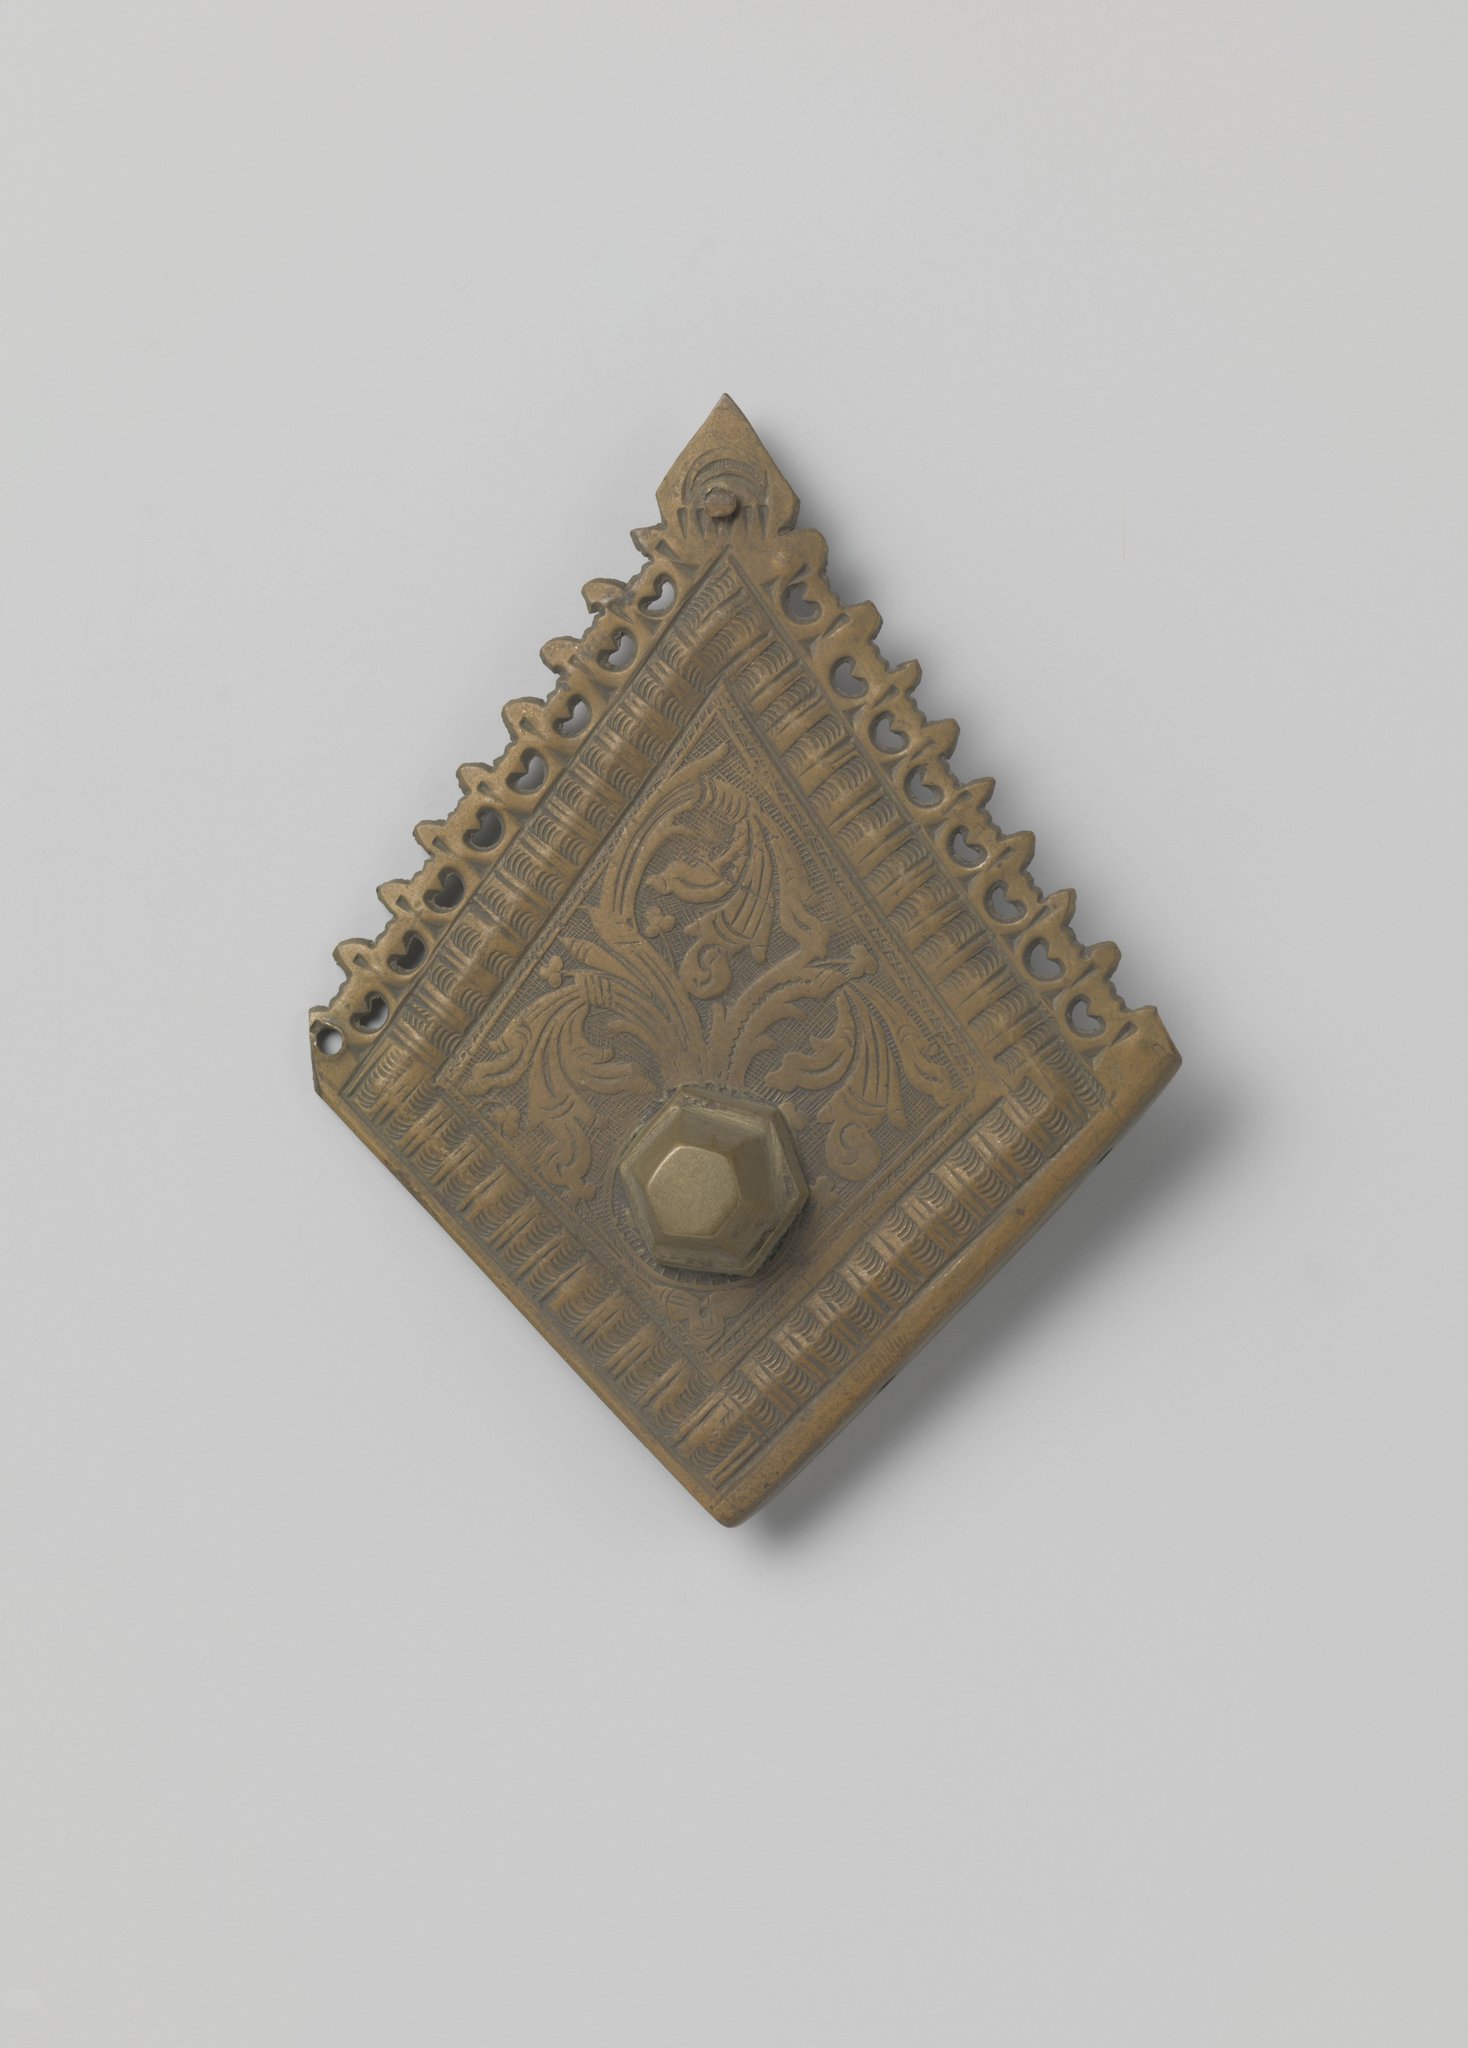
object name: binding finishing hardware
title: Beslag van een missaalband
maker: Anonymous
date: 1450-1500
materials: brass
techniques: cutting, engraving, punching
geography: germany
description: Tien beslagdelen van een missaalband, van messing. De tien delen zijn uit koperplaat gesneden, gedreven, gegraveerd en gesponst bewerkt. Op ieder van hen is een koperen knop met zeven facetten geklonken. Zij zijn voorzien van gaatjes op de hoeken of langs de rand om nagels te kunnen inslaan, waarmee zij op de boekband waren bevetstigd. Vier hoekstukken hebben aan twee kanten een naar achter omgeslagen rand. De overige vier hebben dat slechts aan de boven- of onderkant (deze waren geplaatst tegen de rug van het boek). Van ieder hoekstuk zijn twee kanten kanten afgezet met een open rand van kruisbloemen. Het veld in het midden wordt ingenomen door drie gestilleerde ranken. Het ornament op de middenstukken bestaat op de hoeken uit een plant met drie bladeren en twee bloemen in een pot. De vier gedeelten daartussen worden ingenomen door fantasiegedrochten.